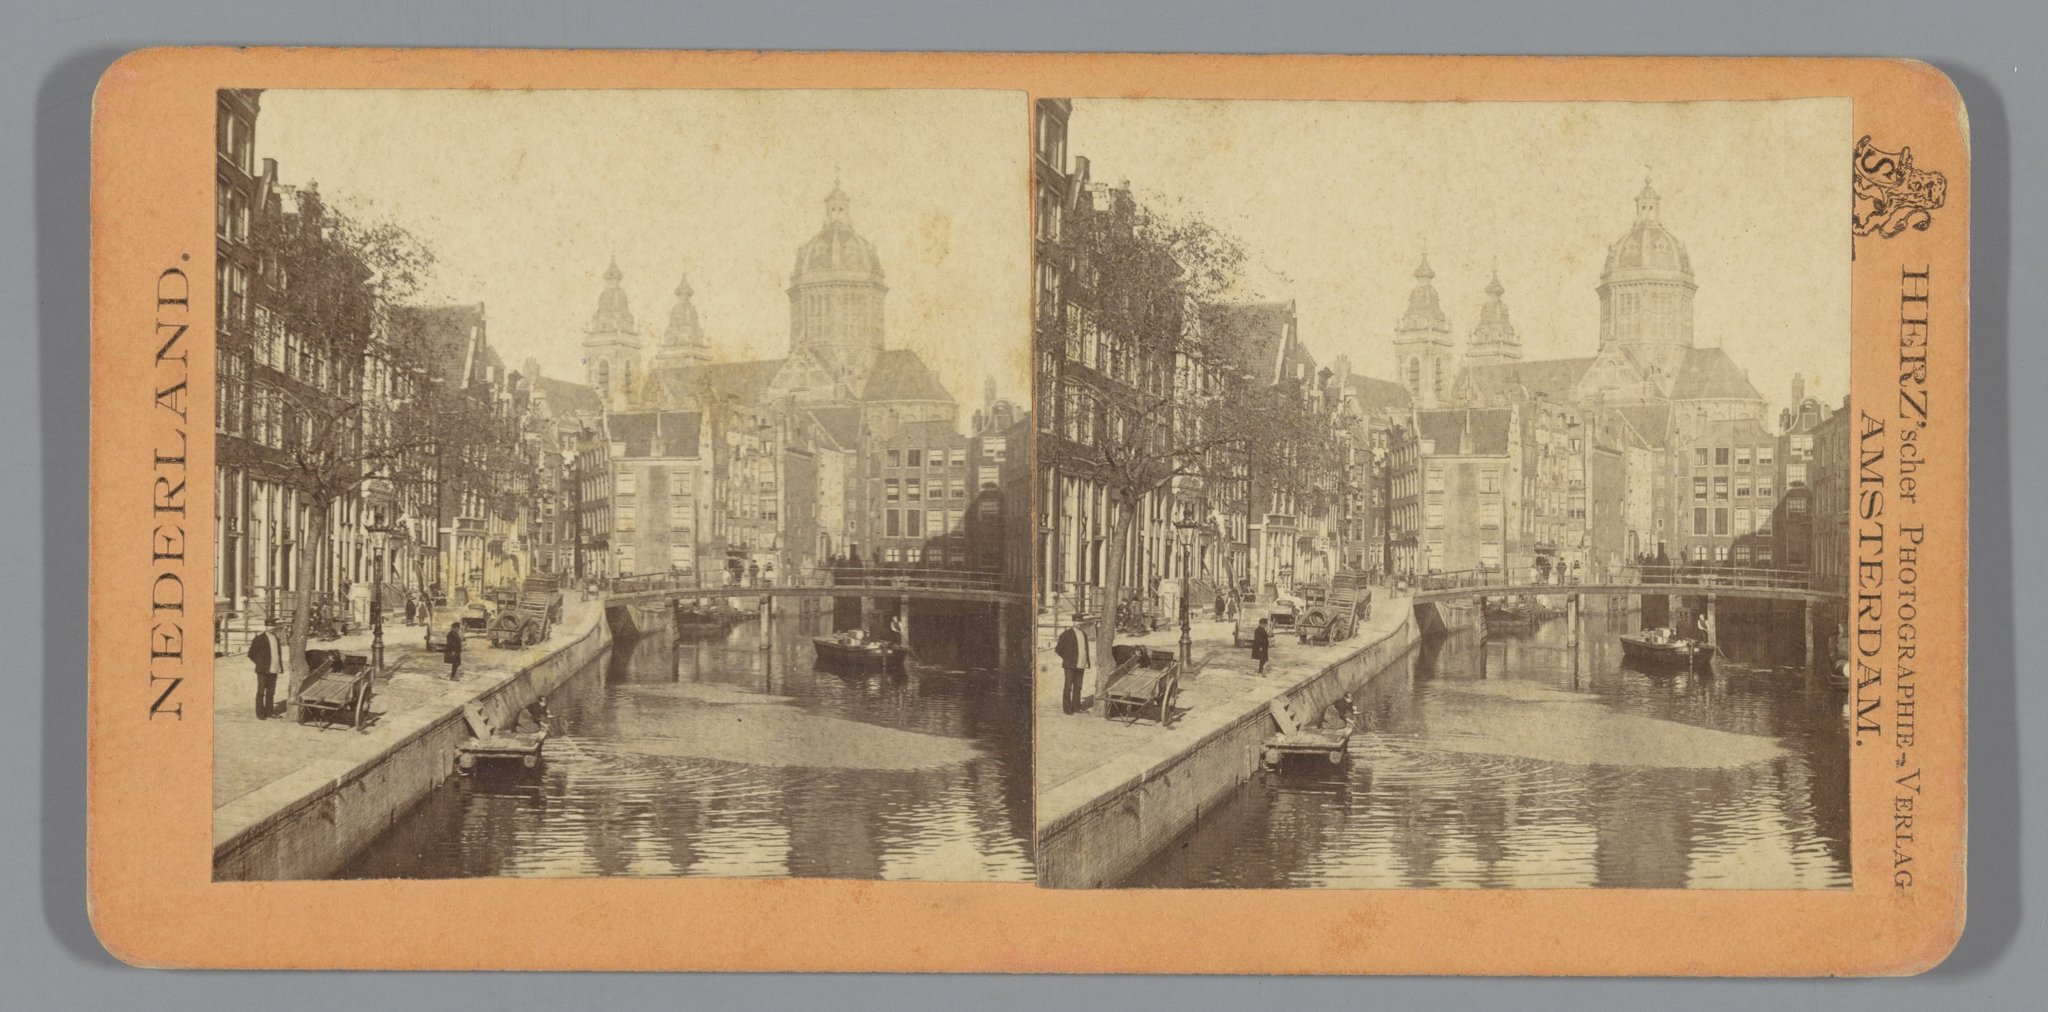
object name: stereograph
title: Oudezijds Voorburgwal en de Sint-Nicolaaskerk, Amsterdam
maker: sigmund löw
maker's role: publisher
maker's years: 1845-1920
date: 1892-1902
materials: cardboard, paper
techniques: albumen print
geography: amsterdam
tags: church (exterior), canals, waters (in city)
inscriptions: inscription: ‘85 Amsterdam/ O.Z. Voorburgwal’